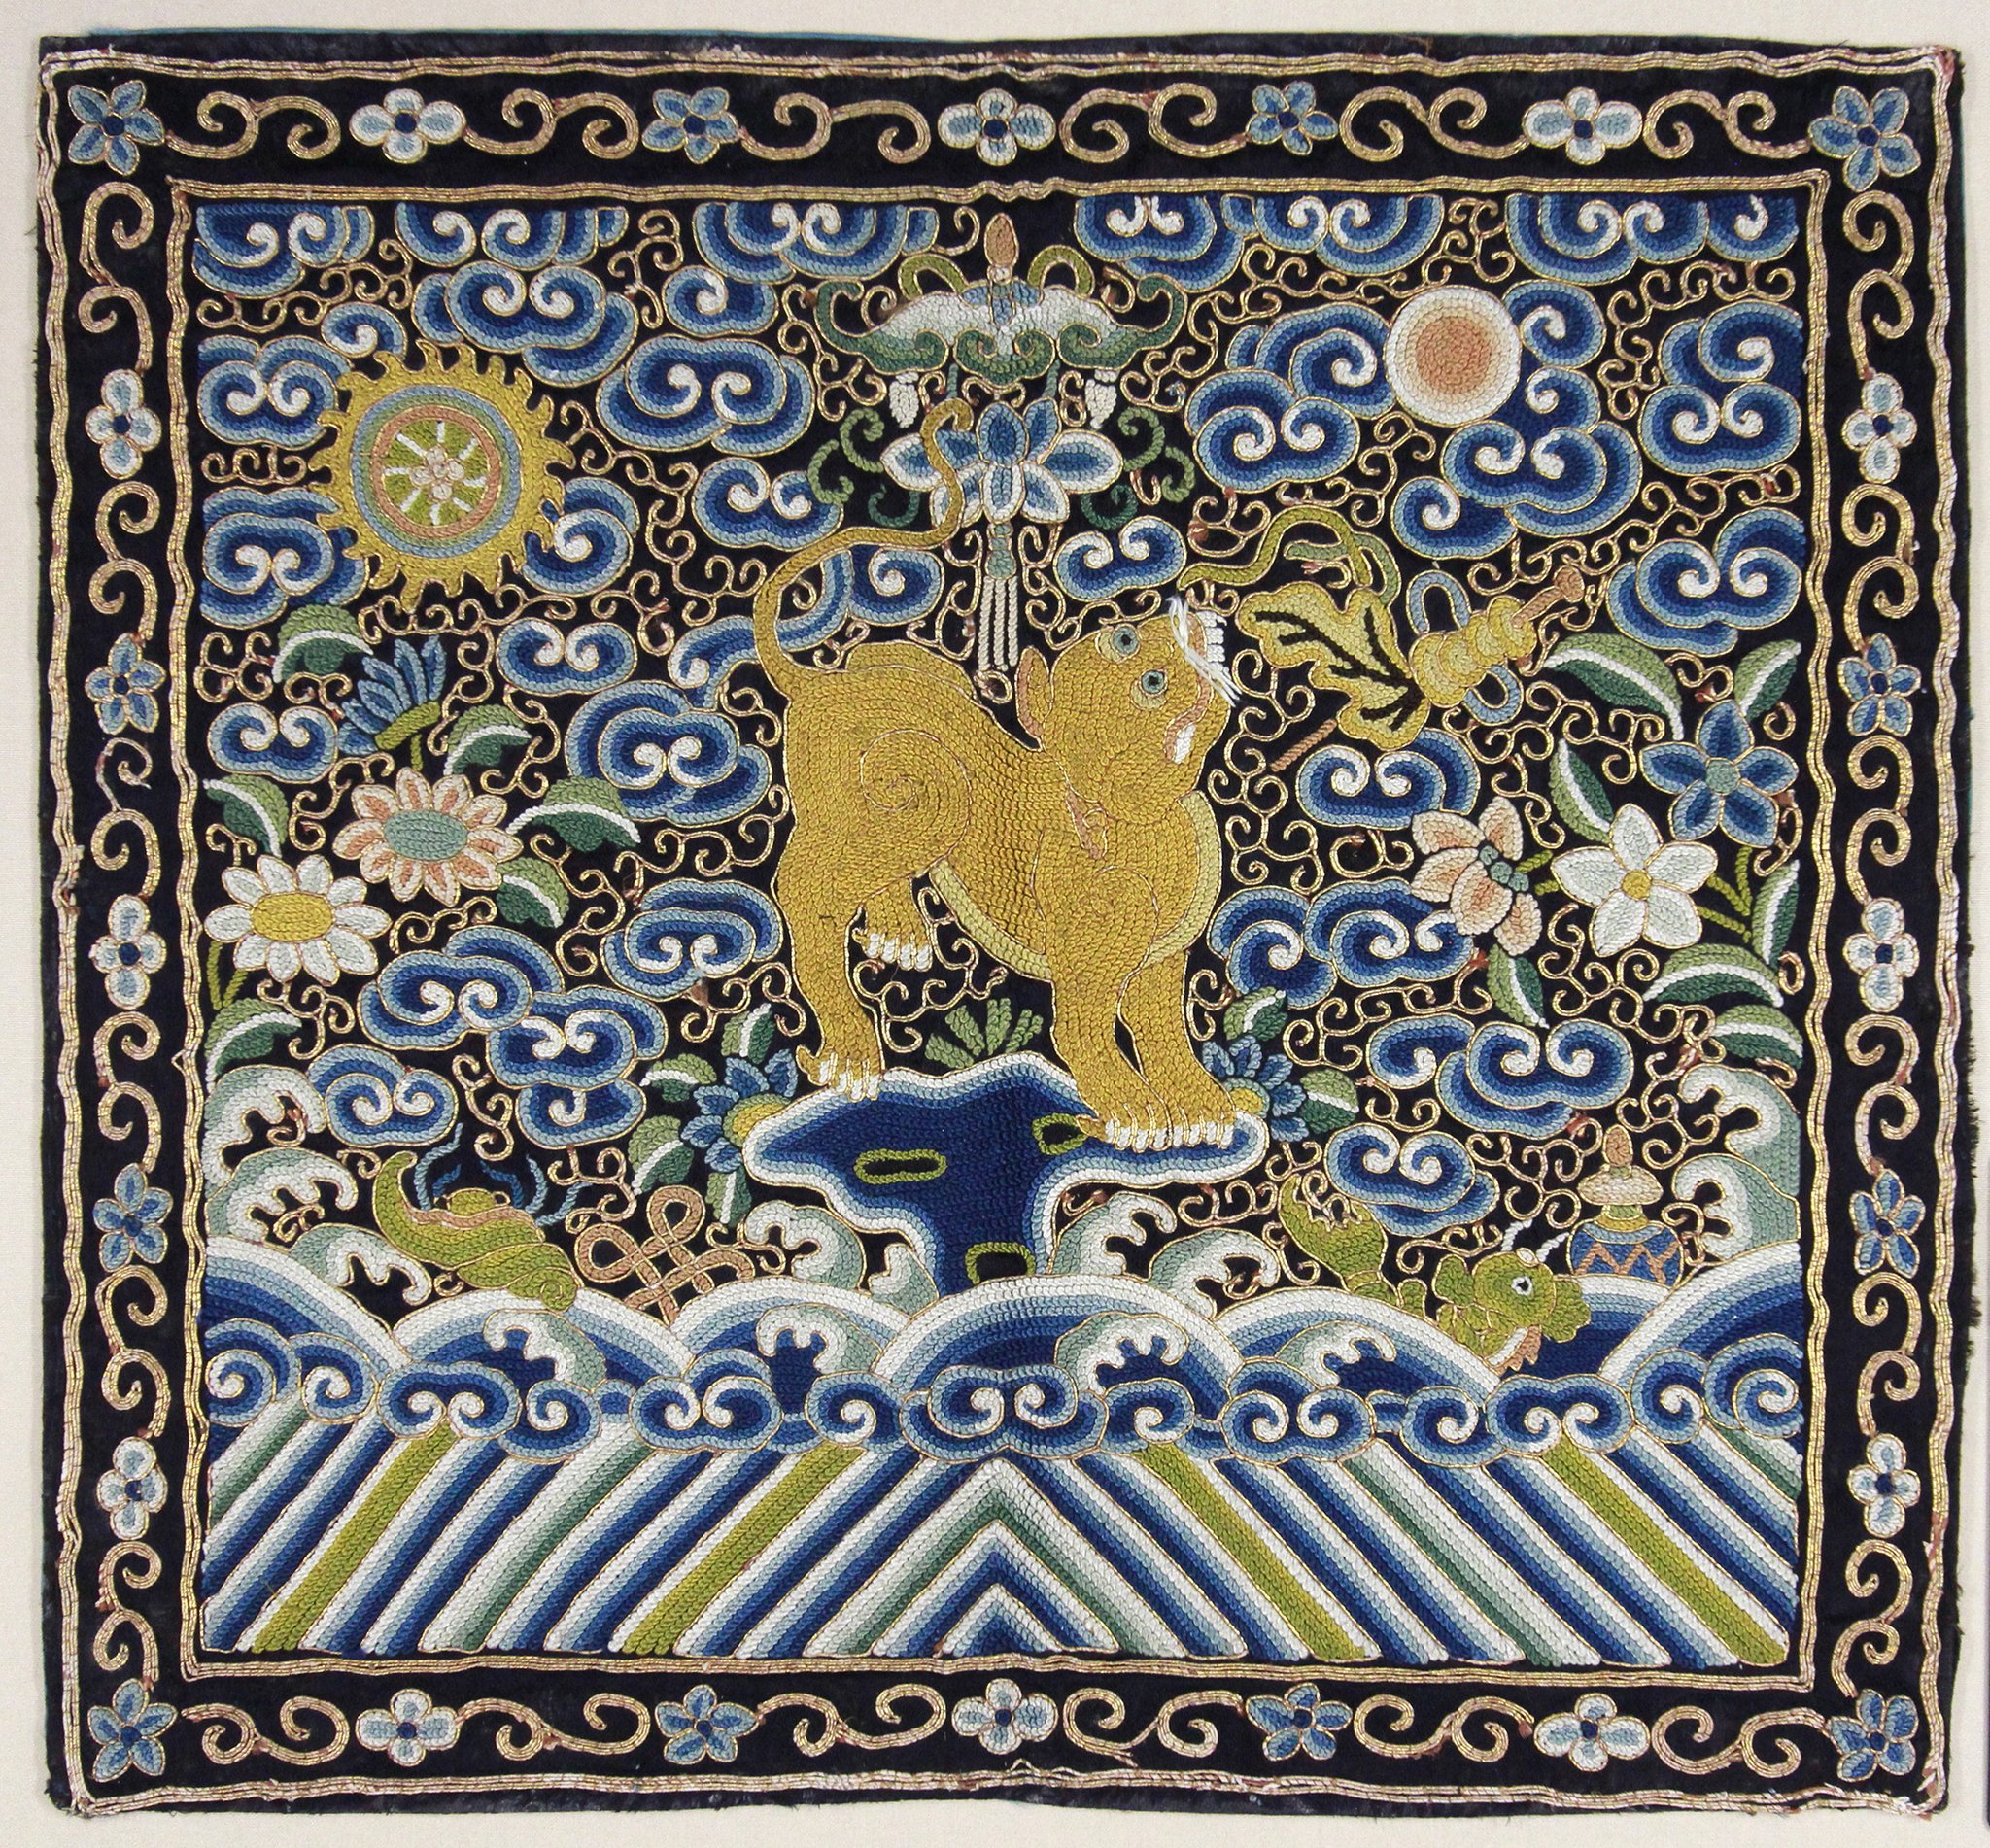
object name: rank badge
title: Rank badge with tiger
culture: chinese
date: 1767-1800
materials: metal thread, silk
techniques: embroidery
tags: animals,tigers